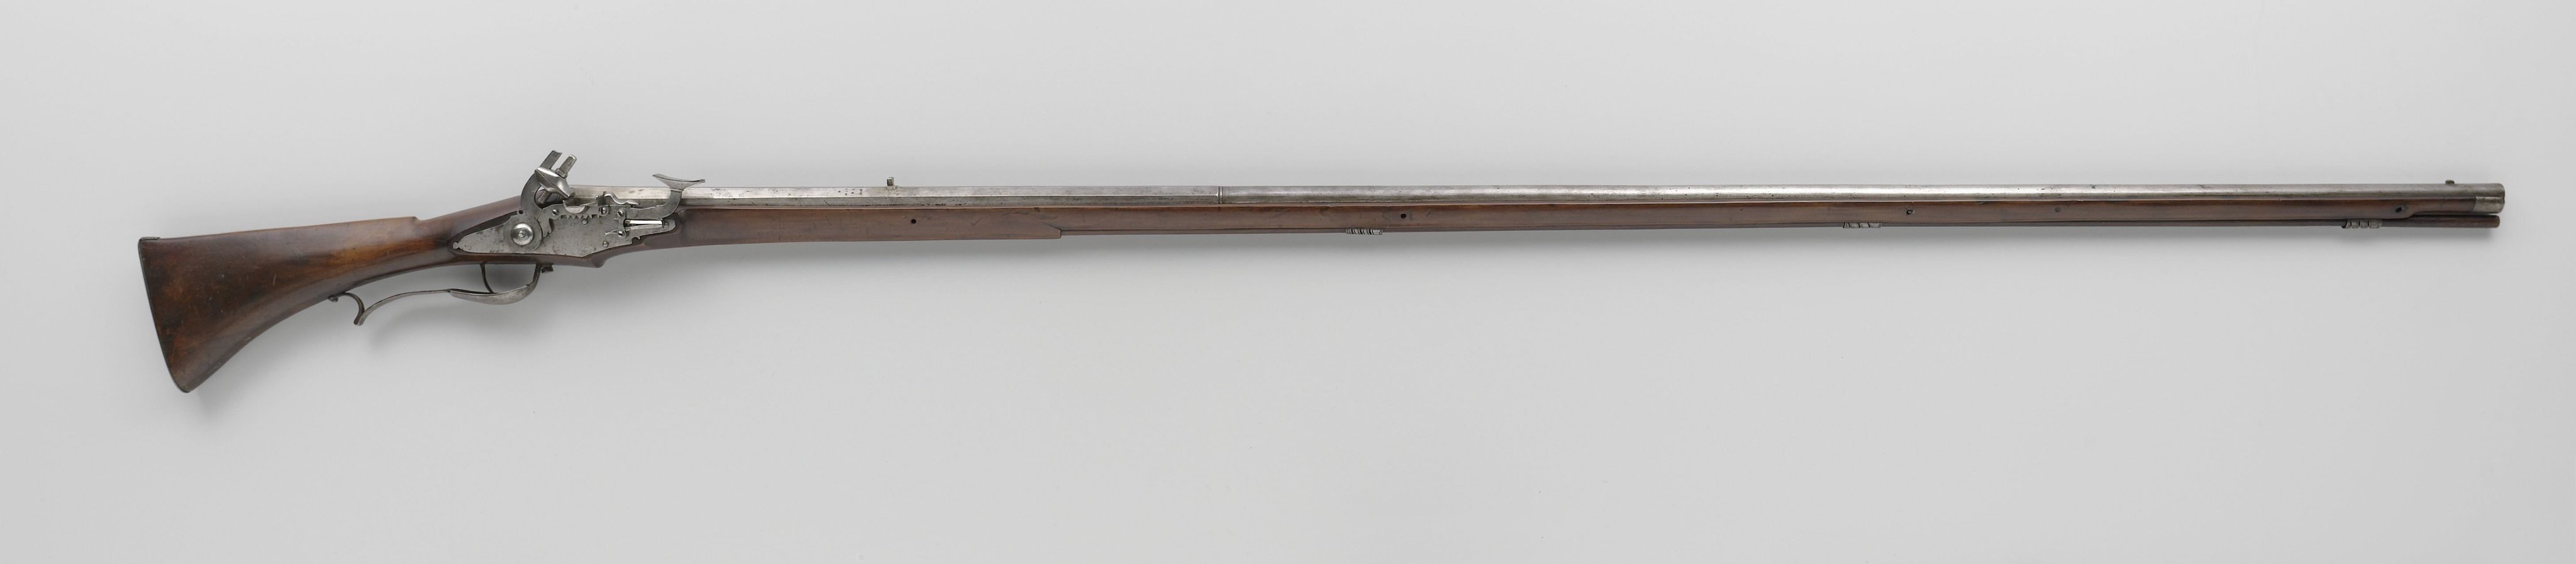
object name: snaphaangeweer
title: Snaphaanmusket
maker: Anonymous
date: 1626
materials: horn, iron, wood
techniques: printing, engraving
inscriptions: stamp: ‘MK’, inscription: ‘IACOB // ROLLIN // 1626PRIN’